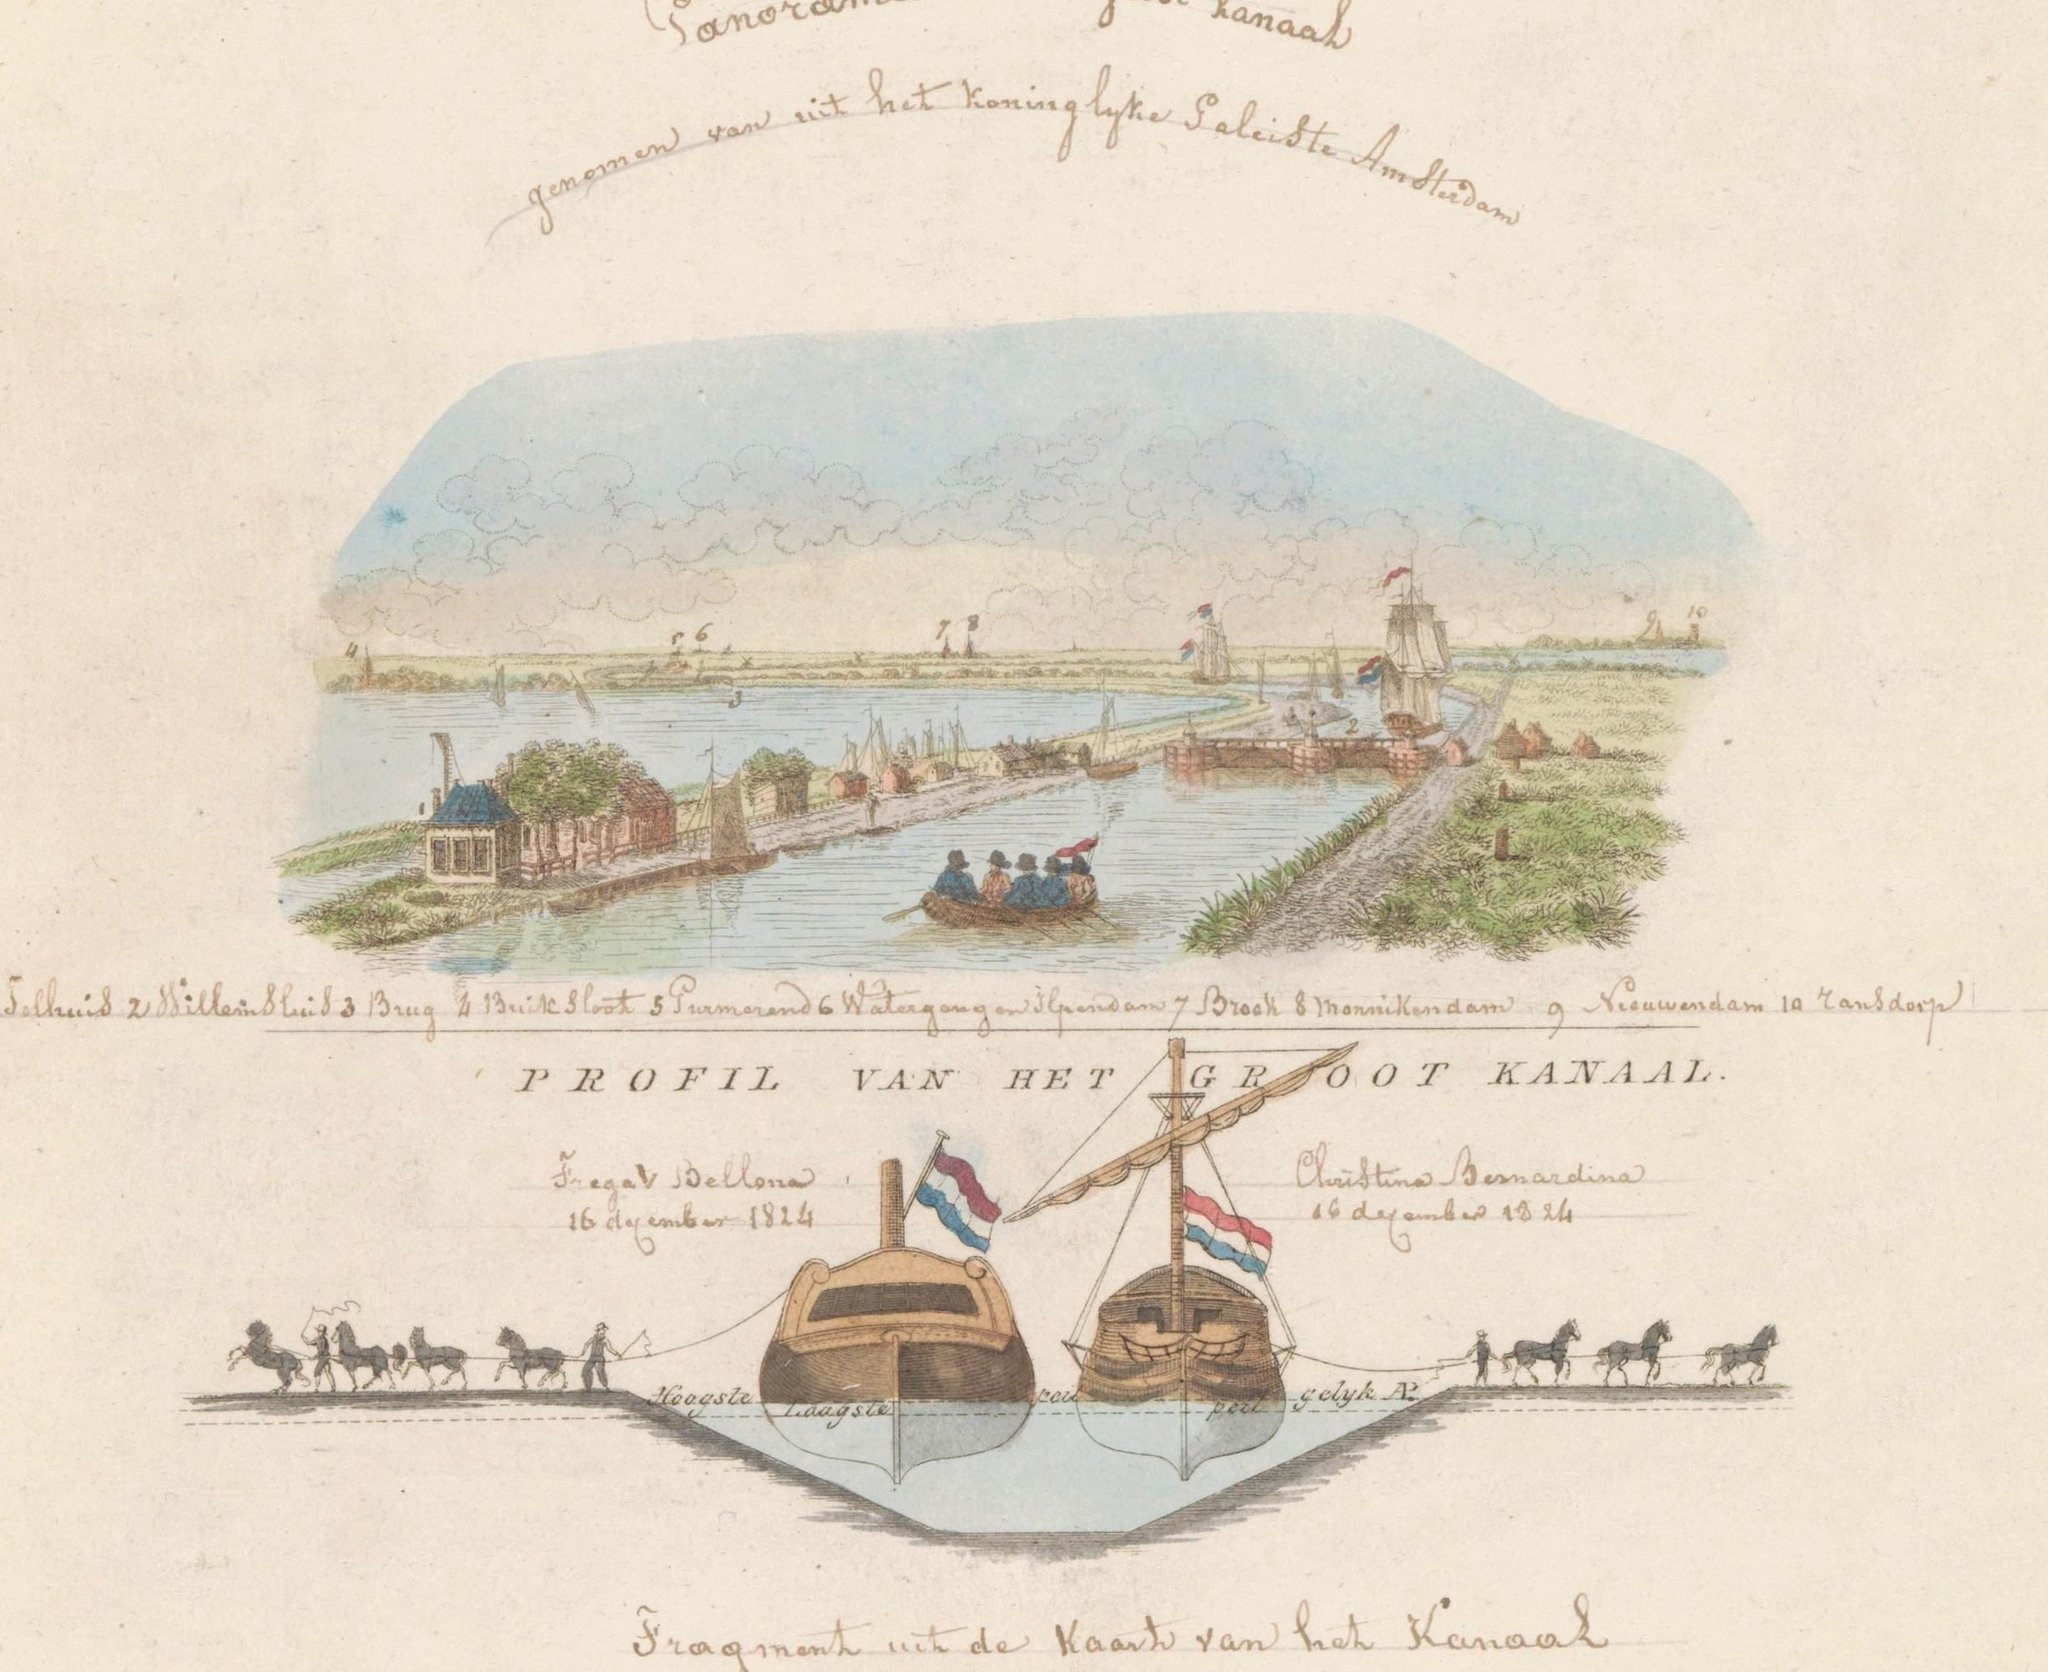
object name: print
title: Panorama van het groot Kanaal, genomen van uit het Koninglijke Paleis te Amsterdam / Profil van het Groot Kanaal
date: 1824-1825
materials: paper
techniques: etching, hand coloring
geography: amsterdam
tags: sluice, weir, canal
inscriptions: inscription: ‘Fragment uit de Kaart van het Kanaal’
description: Twee afbeeldingen van het Noordhollandsch Kanaal, december 1824. Bovenaan een gezicht op de Tolhuis bij de Willemssluis, in het onderschrift de legenda 1-10 op de met de hand in de voorstelling geschreven nummers. Onderaan een dwarsdoorsnede van het kanaal met de doorvaart op 16 december van de twee schepen, het fregat Bellona en het schip de Christina Bernardina. Onderdeel van een plaatwerk uit ca. 1824-1825 met 74 (ongenummerde) platen van de belangrijkste topografische gezichten en verschillende zeden en gewoonten in het Verenigd Koninkrijk der Nederlanden.